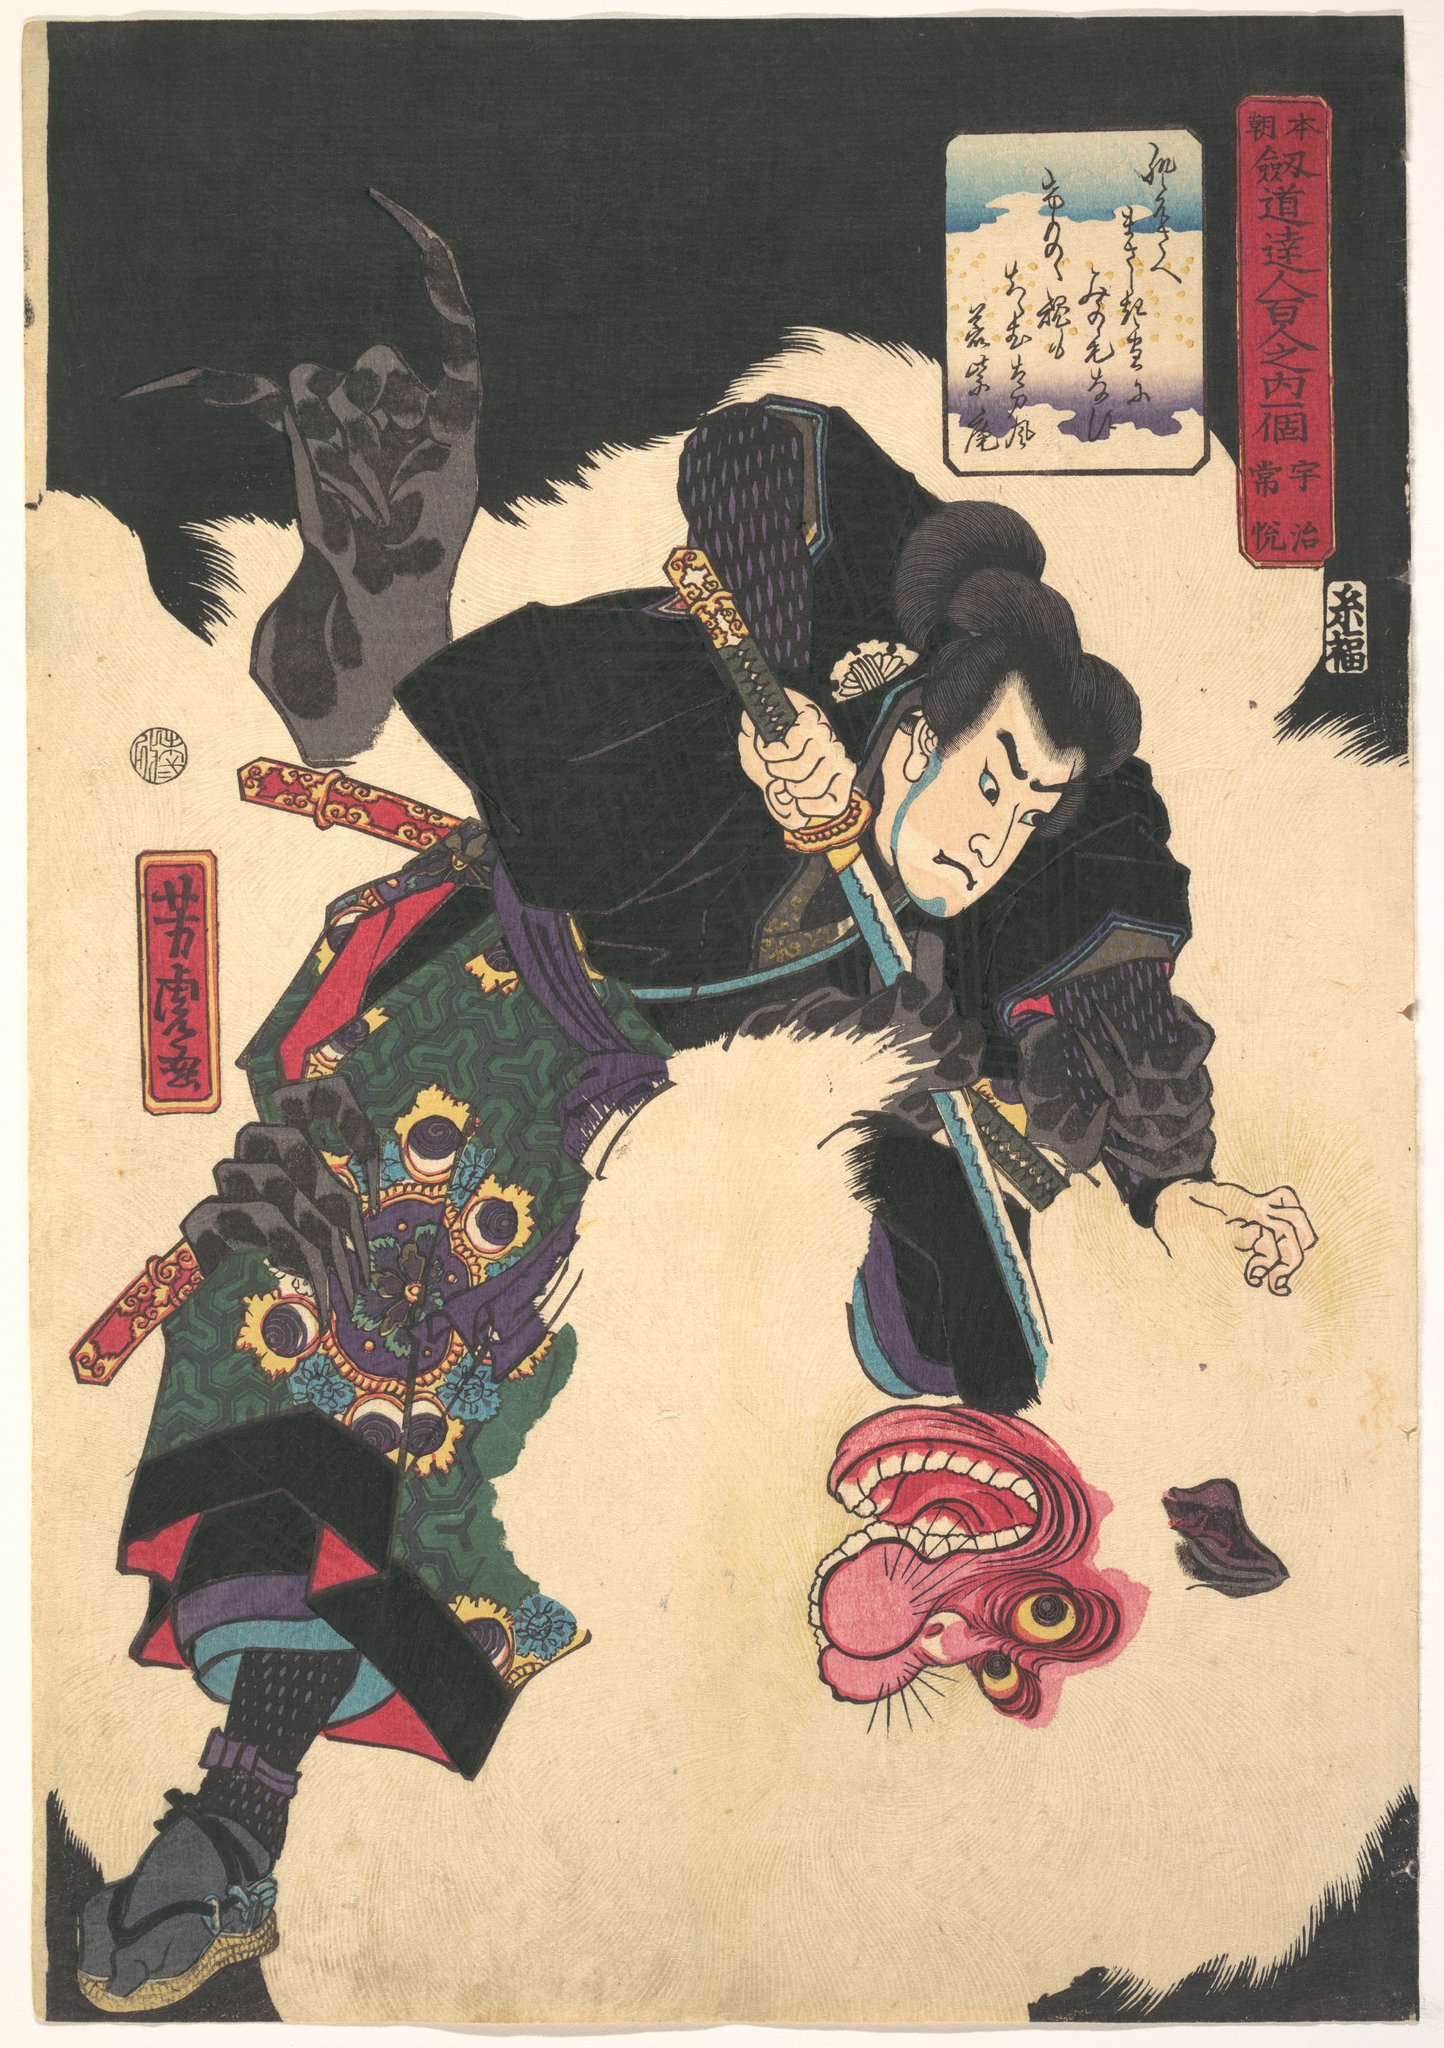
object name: woodblock print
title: The Warrior Slaying the Giant White Hihi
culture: japanese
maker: utagawa yoshitora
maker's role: artist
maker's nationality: japanese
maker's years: 1845-1880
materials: ink, paper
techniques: woodblock print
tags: animals,swords,men